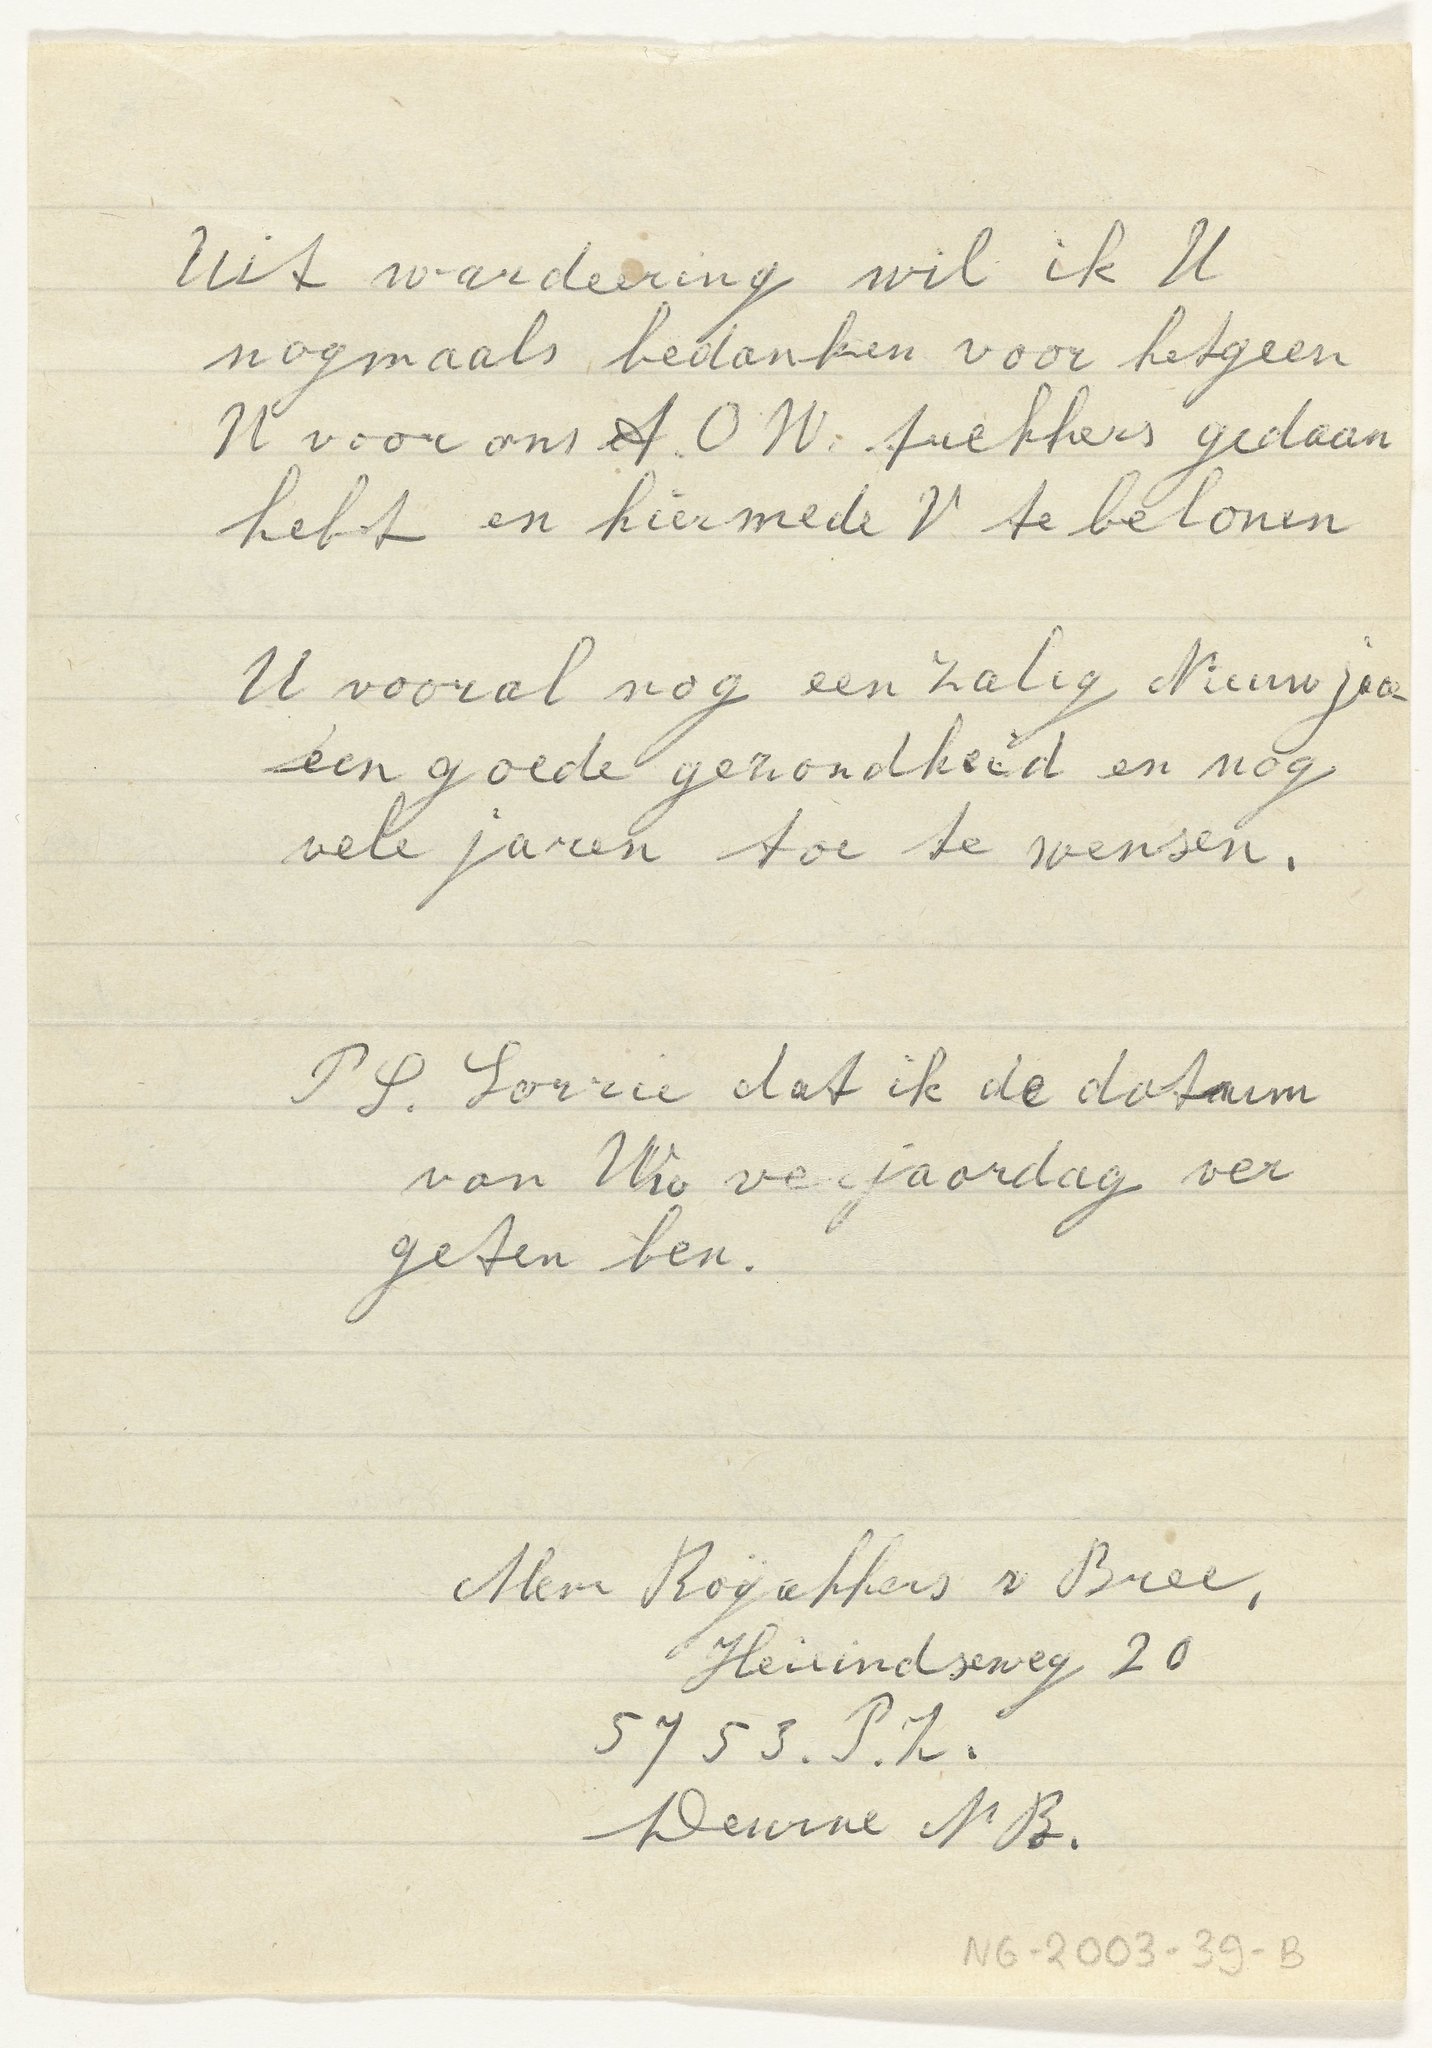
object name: document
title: Briefje bij portretfoto van Willem Drees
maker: wilhelmina roijakkers-van bree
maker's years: 1913-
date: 1982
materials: paper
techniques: writing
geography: deurne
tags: amsterdam, the hague, willem drees, netherlands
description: Letter, 28 December 1982. Mrs Roijakkers-van Bree (b. 1913) took a photo of Drees when he appeared on television for his 96th birthday. She sent the photo to Drees with this letter.